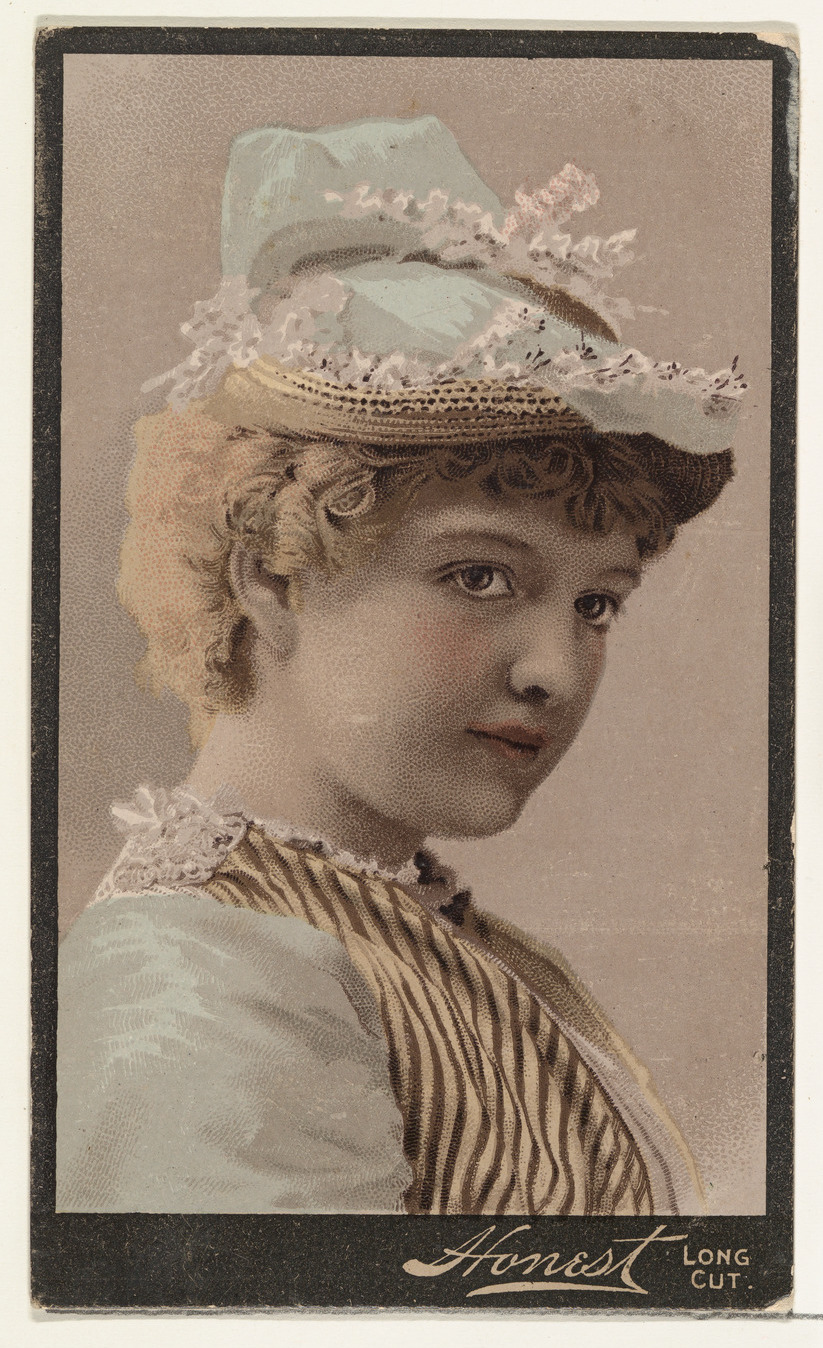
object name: print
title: Blonde actress wearing petite straw-brimmed cap decorated with white flowers, from Stars of the Stage, Third Series (N131) issued by Duke Sons & Co. to promote Honest Long Cut Tobacco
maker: w. duke, sons & co.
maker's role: publisher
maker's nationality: american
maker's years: 1870-1920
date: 1891-1892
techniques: color lithograph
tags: portraits,women,actresses